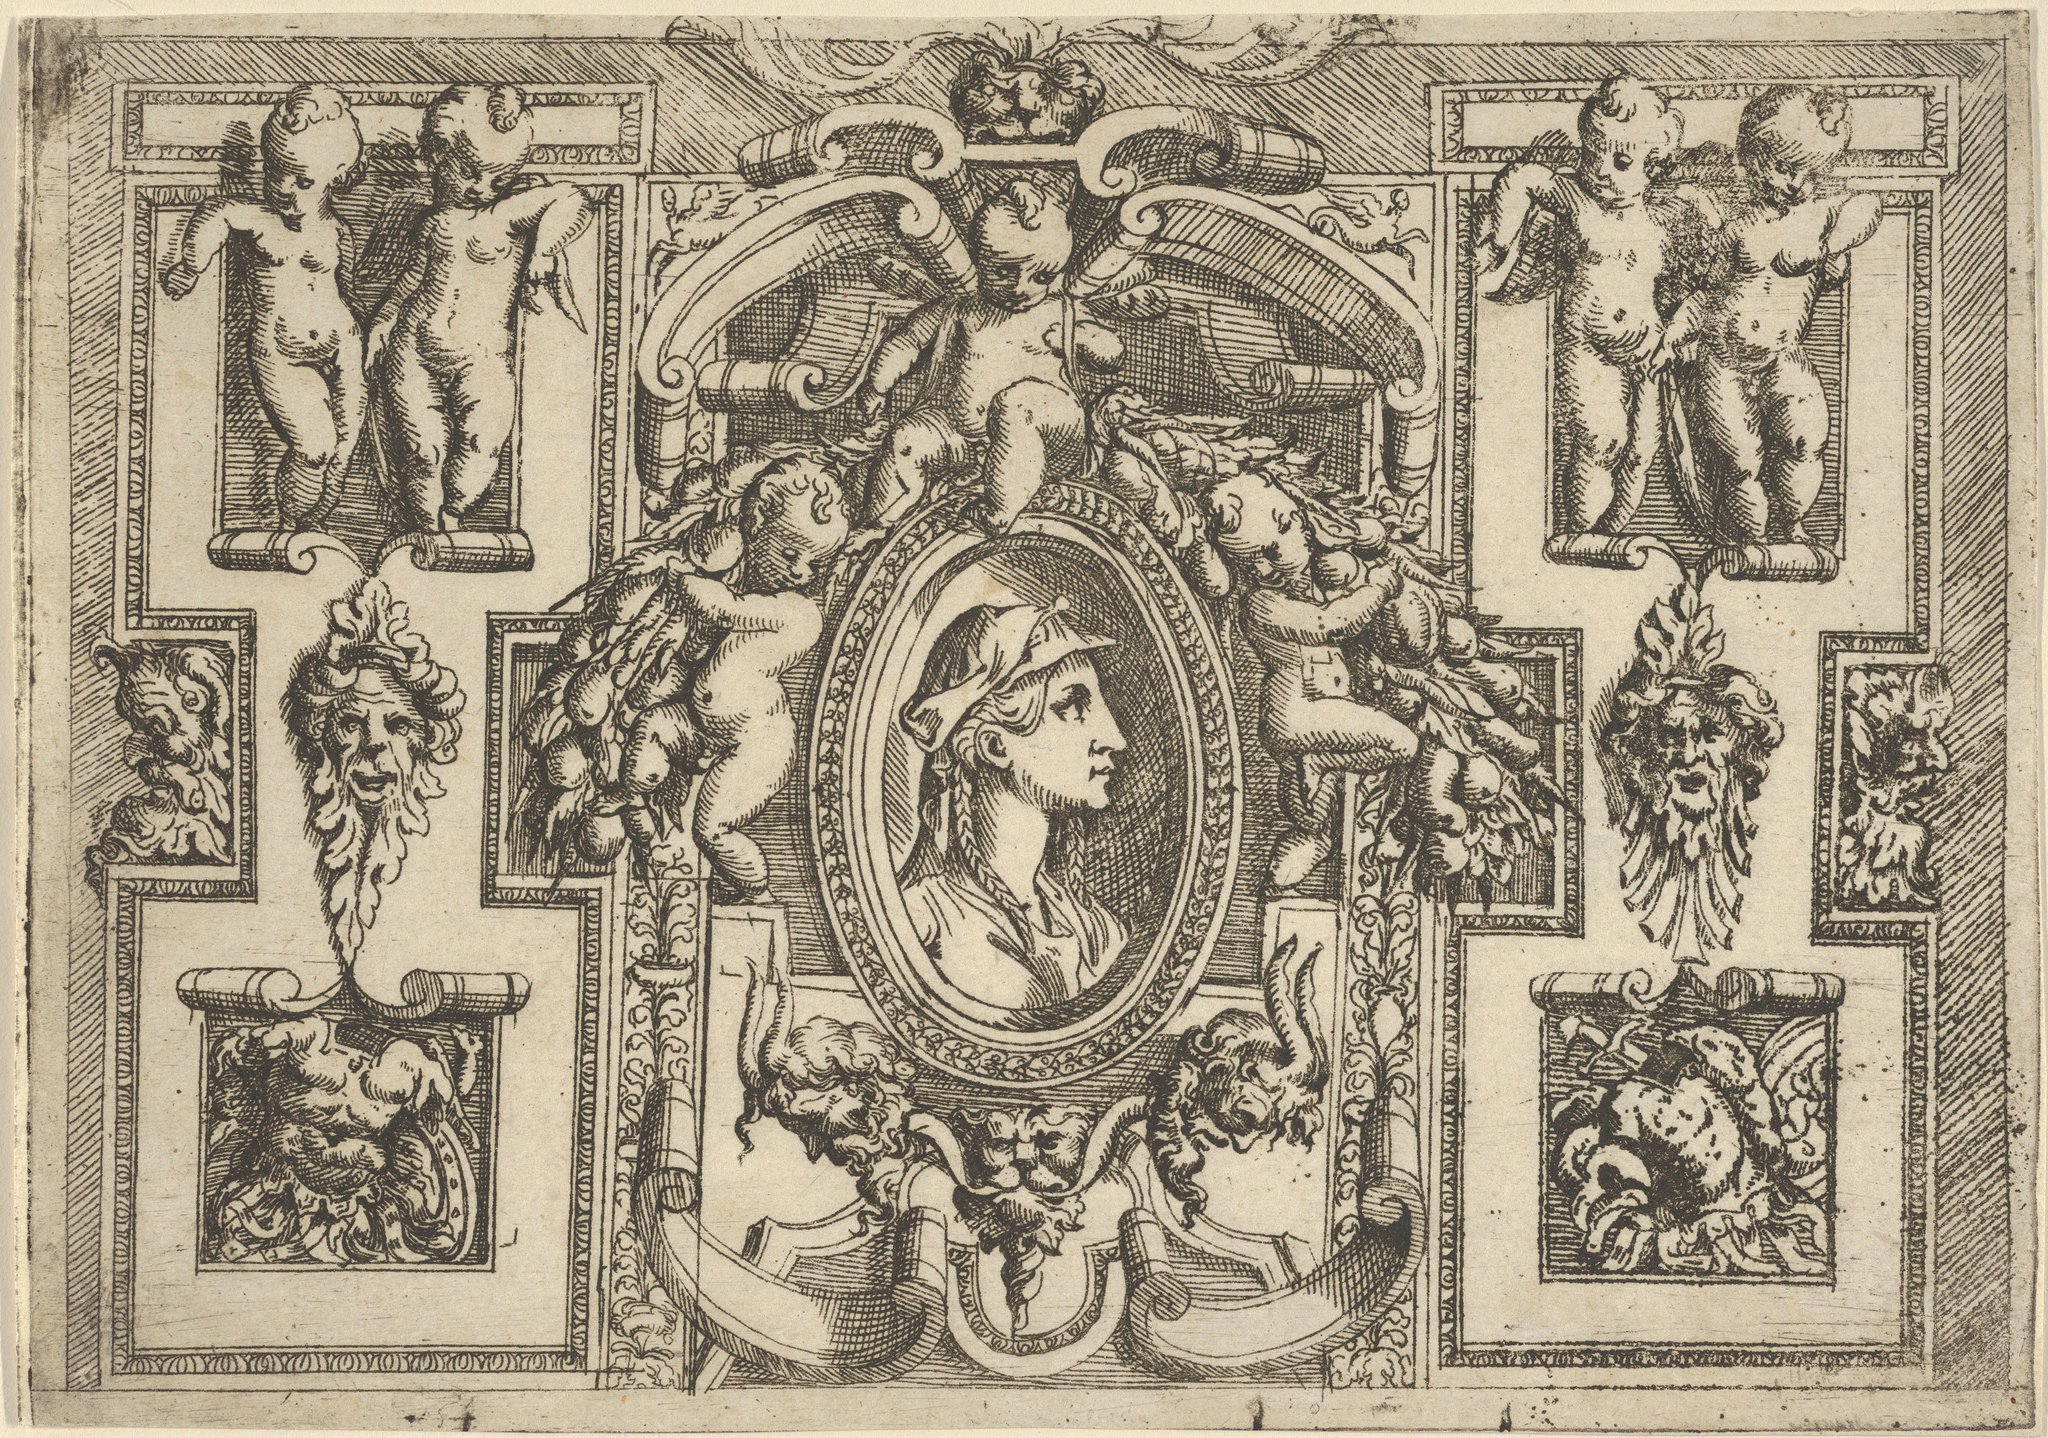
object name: print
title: Bust of a woman in profile facing right, set within an elaborate frame with putti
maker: battista angolo del moro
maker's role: artist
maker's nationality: italian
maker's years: 1515-1573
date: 1540-1580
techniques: etching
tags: profiles,women,putti